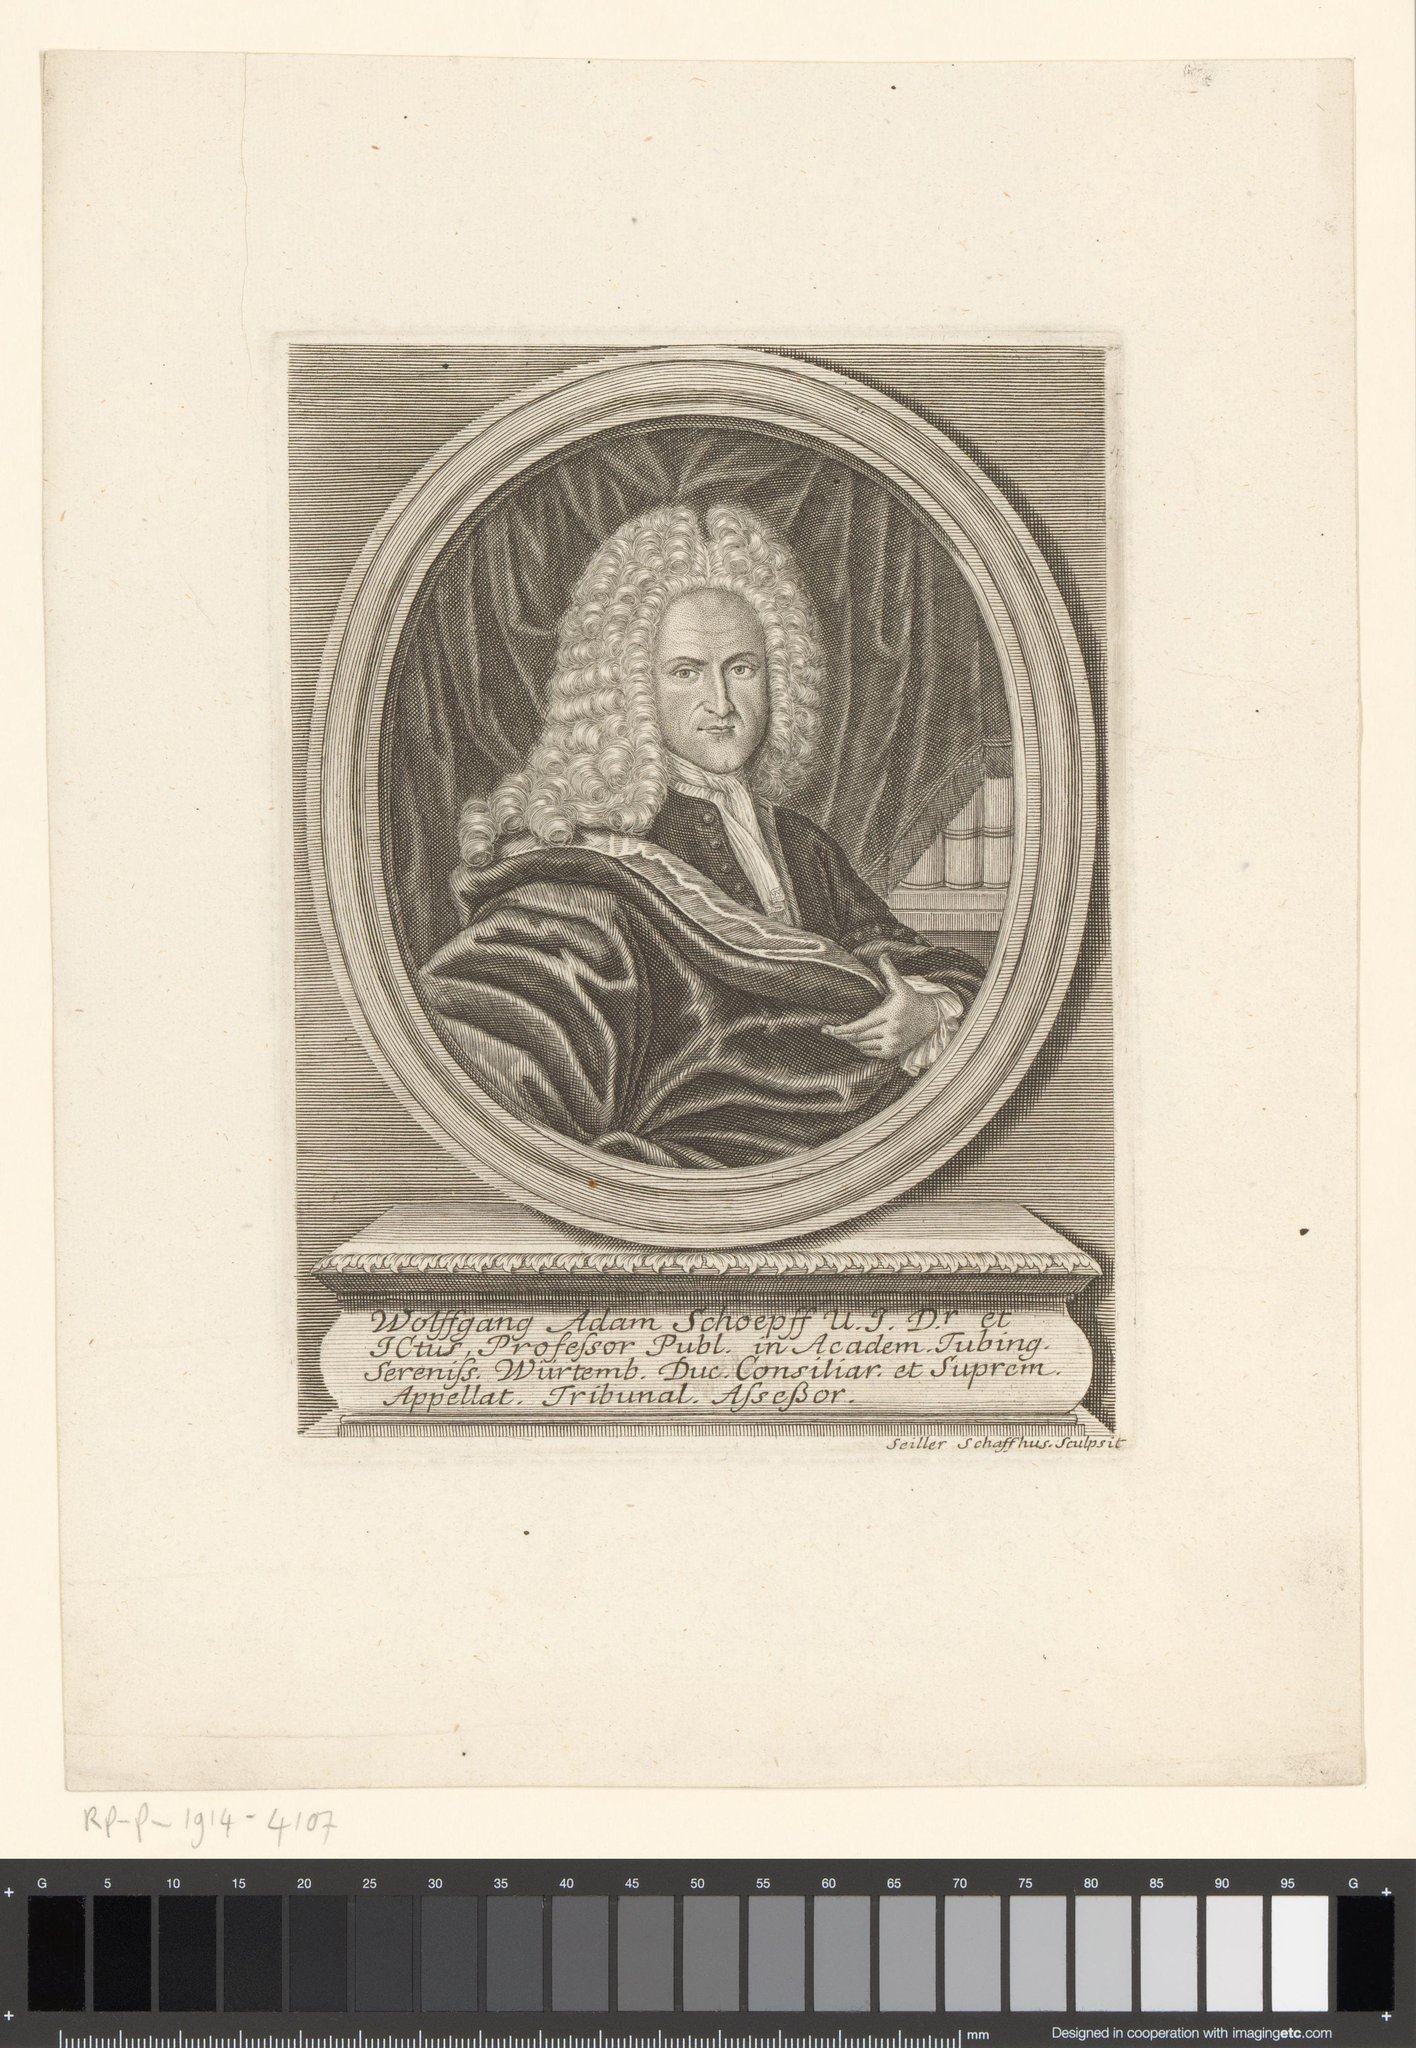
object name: print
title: Portret van Wolfgang Adam Schöpff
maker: johann georg seiller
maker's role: print maker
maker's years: 1663-1740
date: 1699-1740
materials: paper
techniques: engraving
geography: schaffhausen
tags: historical persons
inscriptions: collector's mark: Lugt 2228